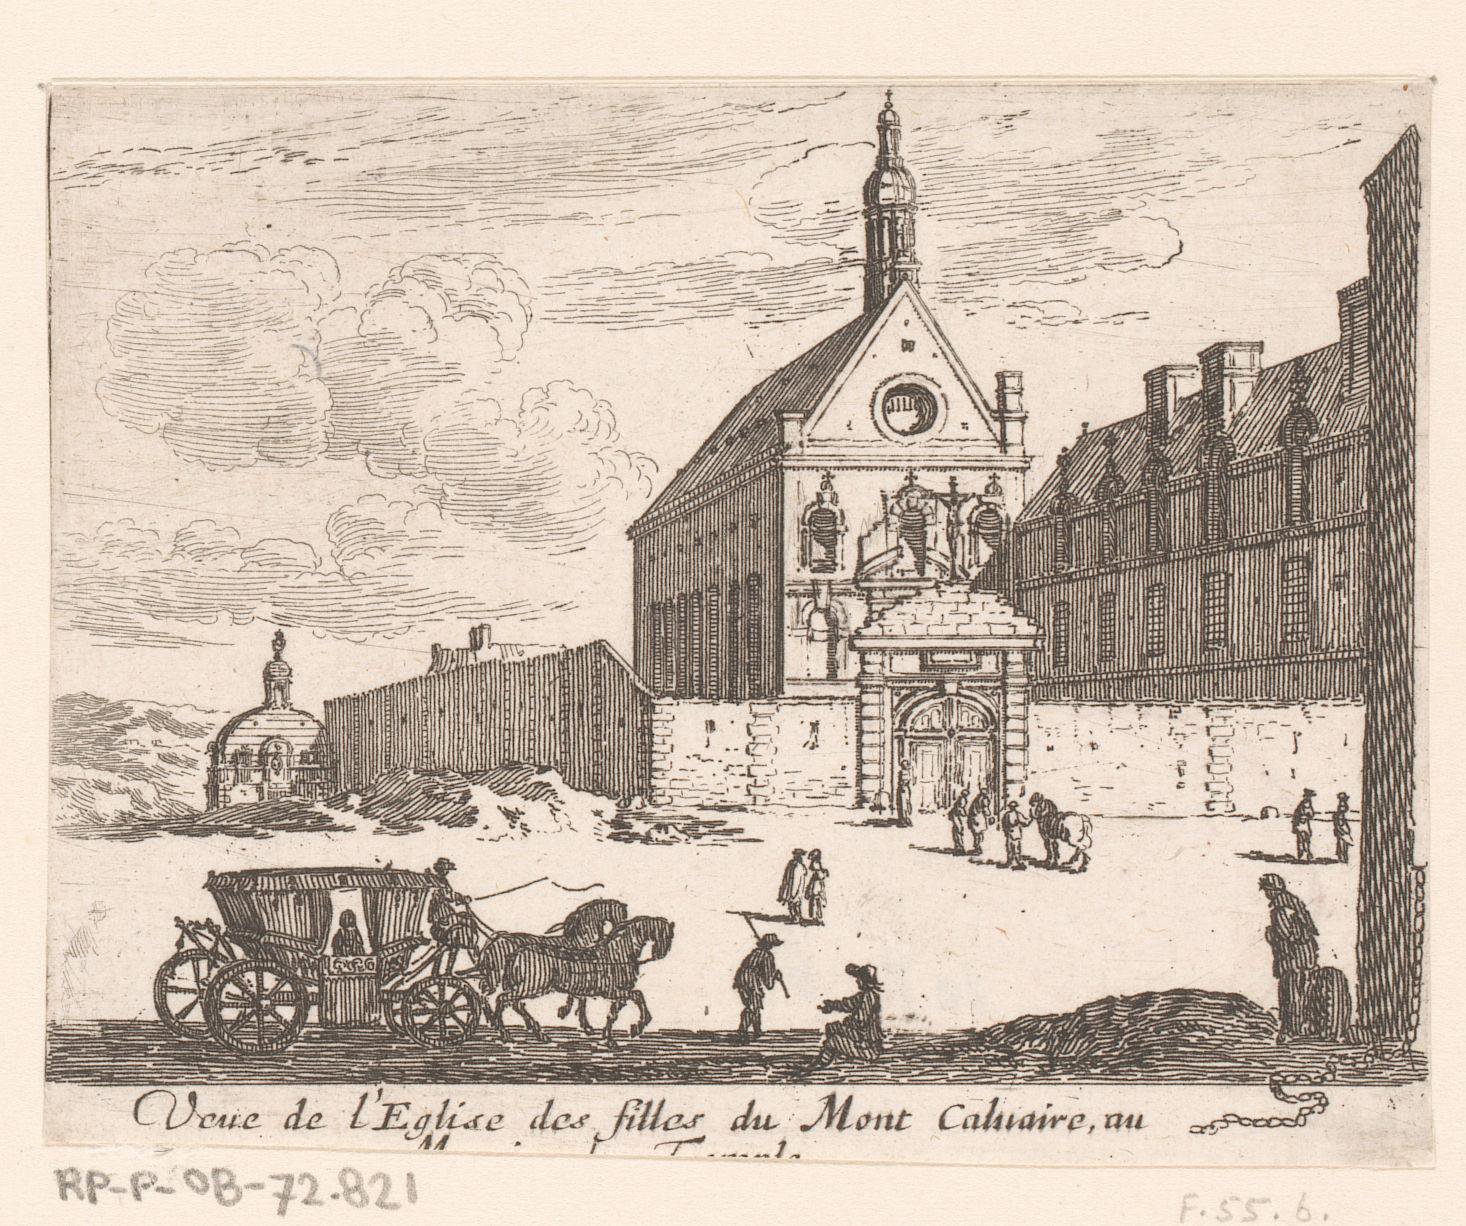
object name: print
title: Veue de l'Eglise des filles du Mont Caluaire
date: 1631-1661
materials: paper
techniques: etching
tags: church (exterior), city-view, and landscape with man-made constructions (+ city(-scape) with figures, staffage), paris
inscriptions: collector's mark: Lugt 240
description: Prent maakt deel uit van een ongenummerde serie van zestien prenten.